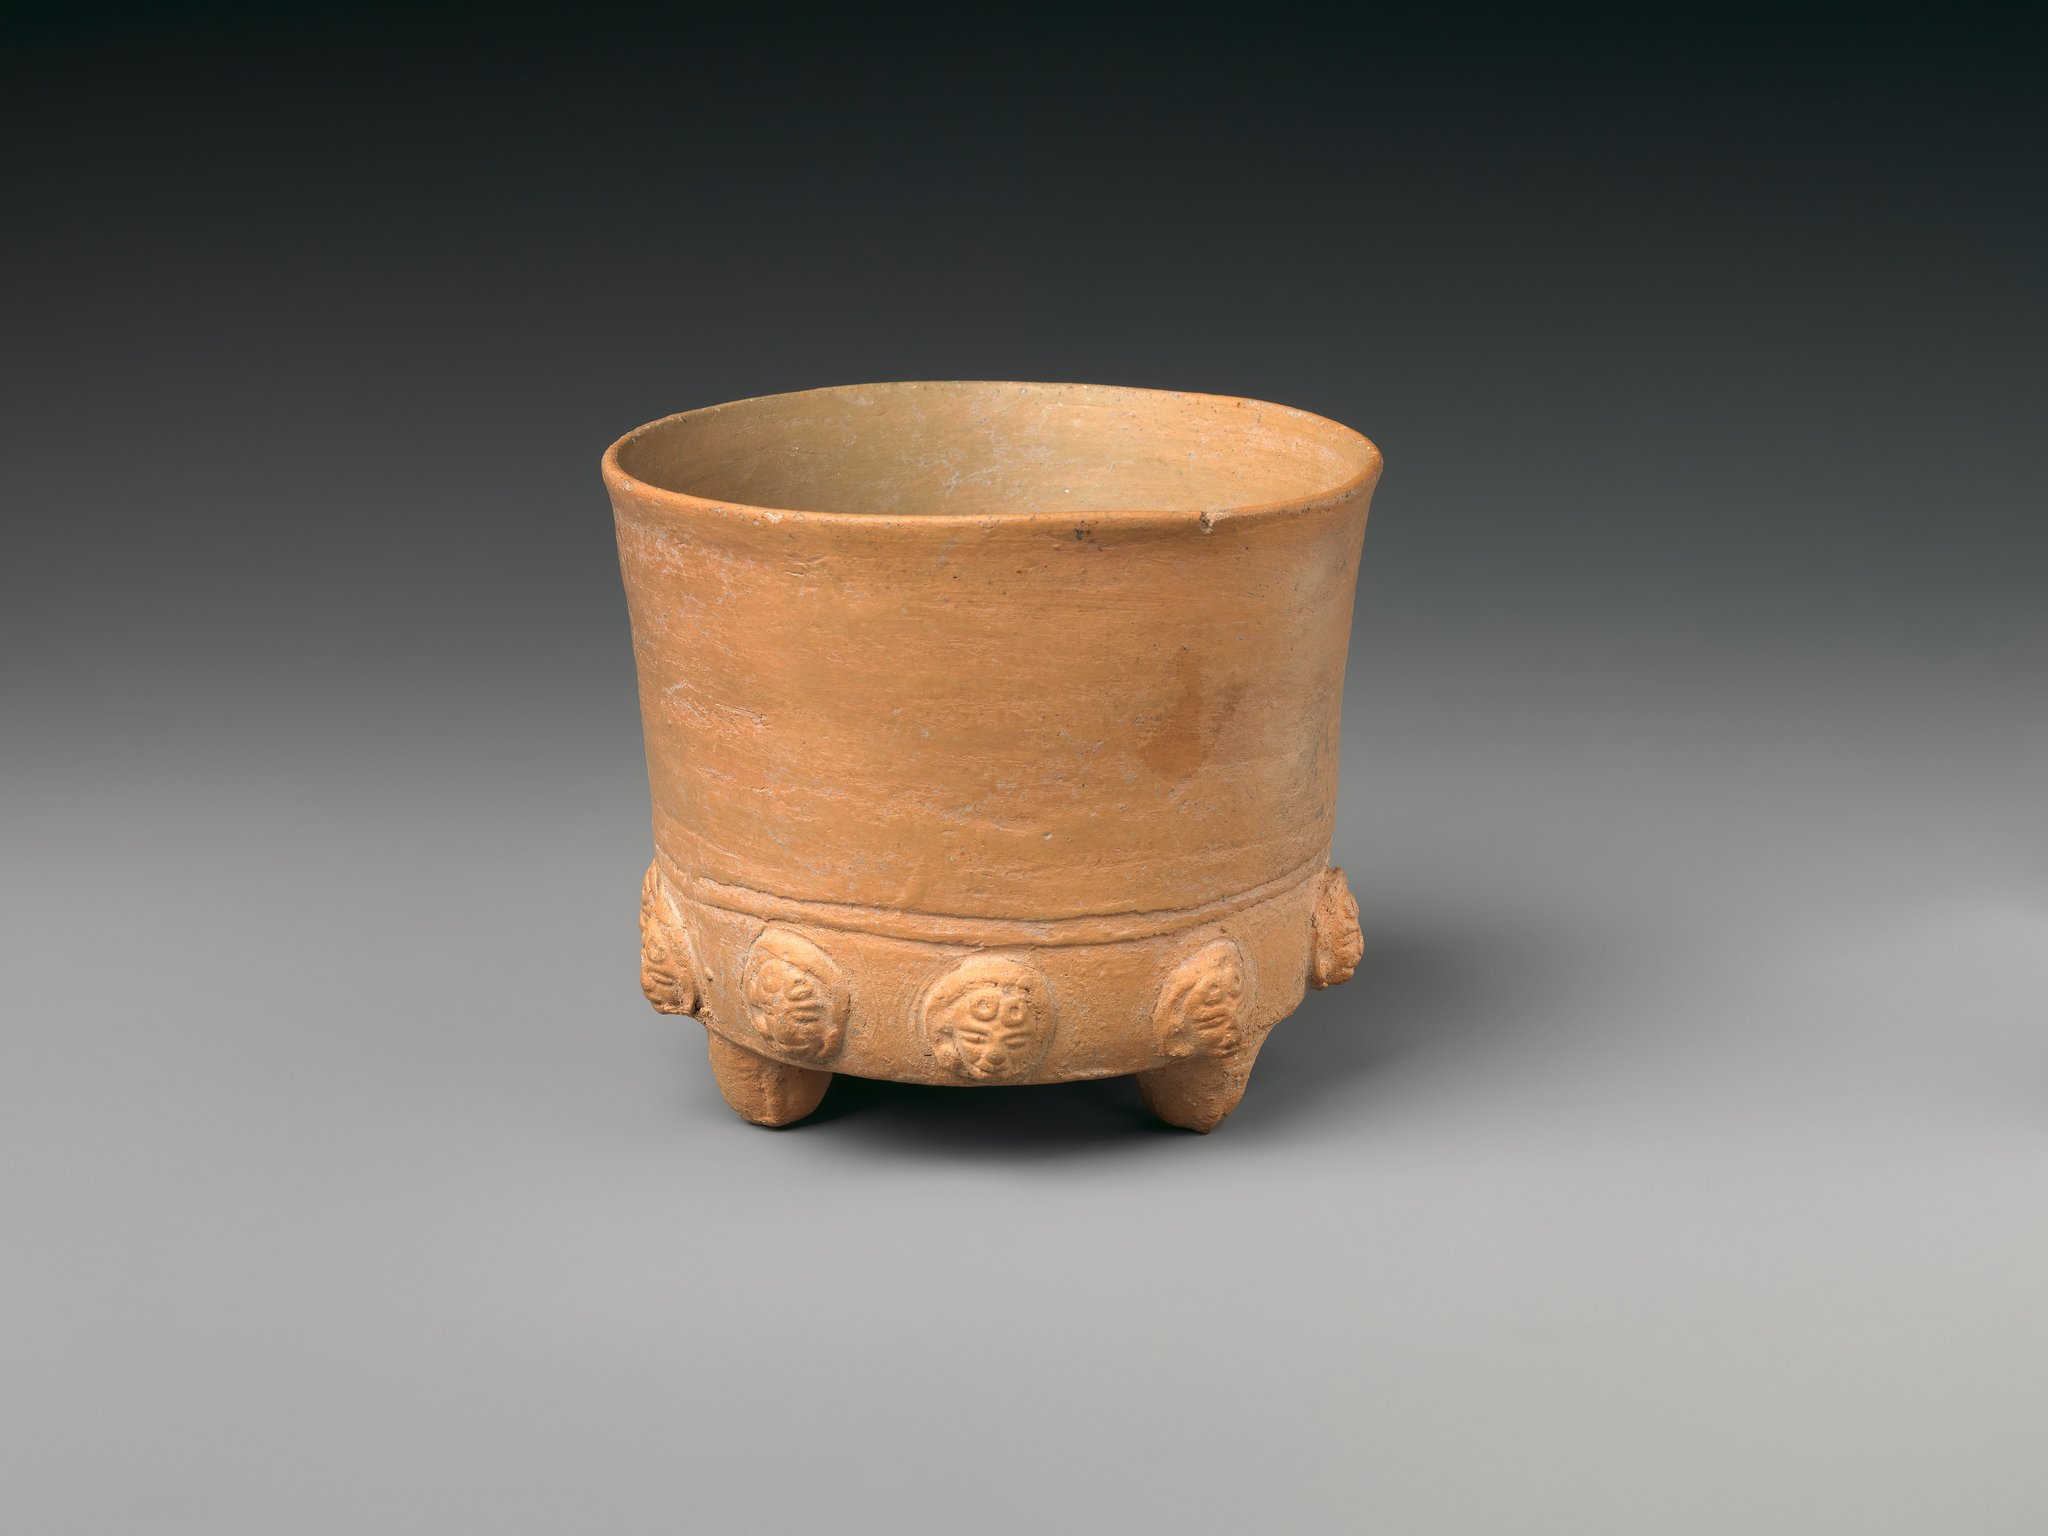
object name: vessel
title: Tripod Vessel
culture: teotihuacan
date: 401-500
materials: ceramic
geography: mexico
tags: faces